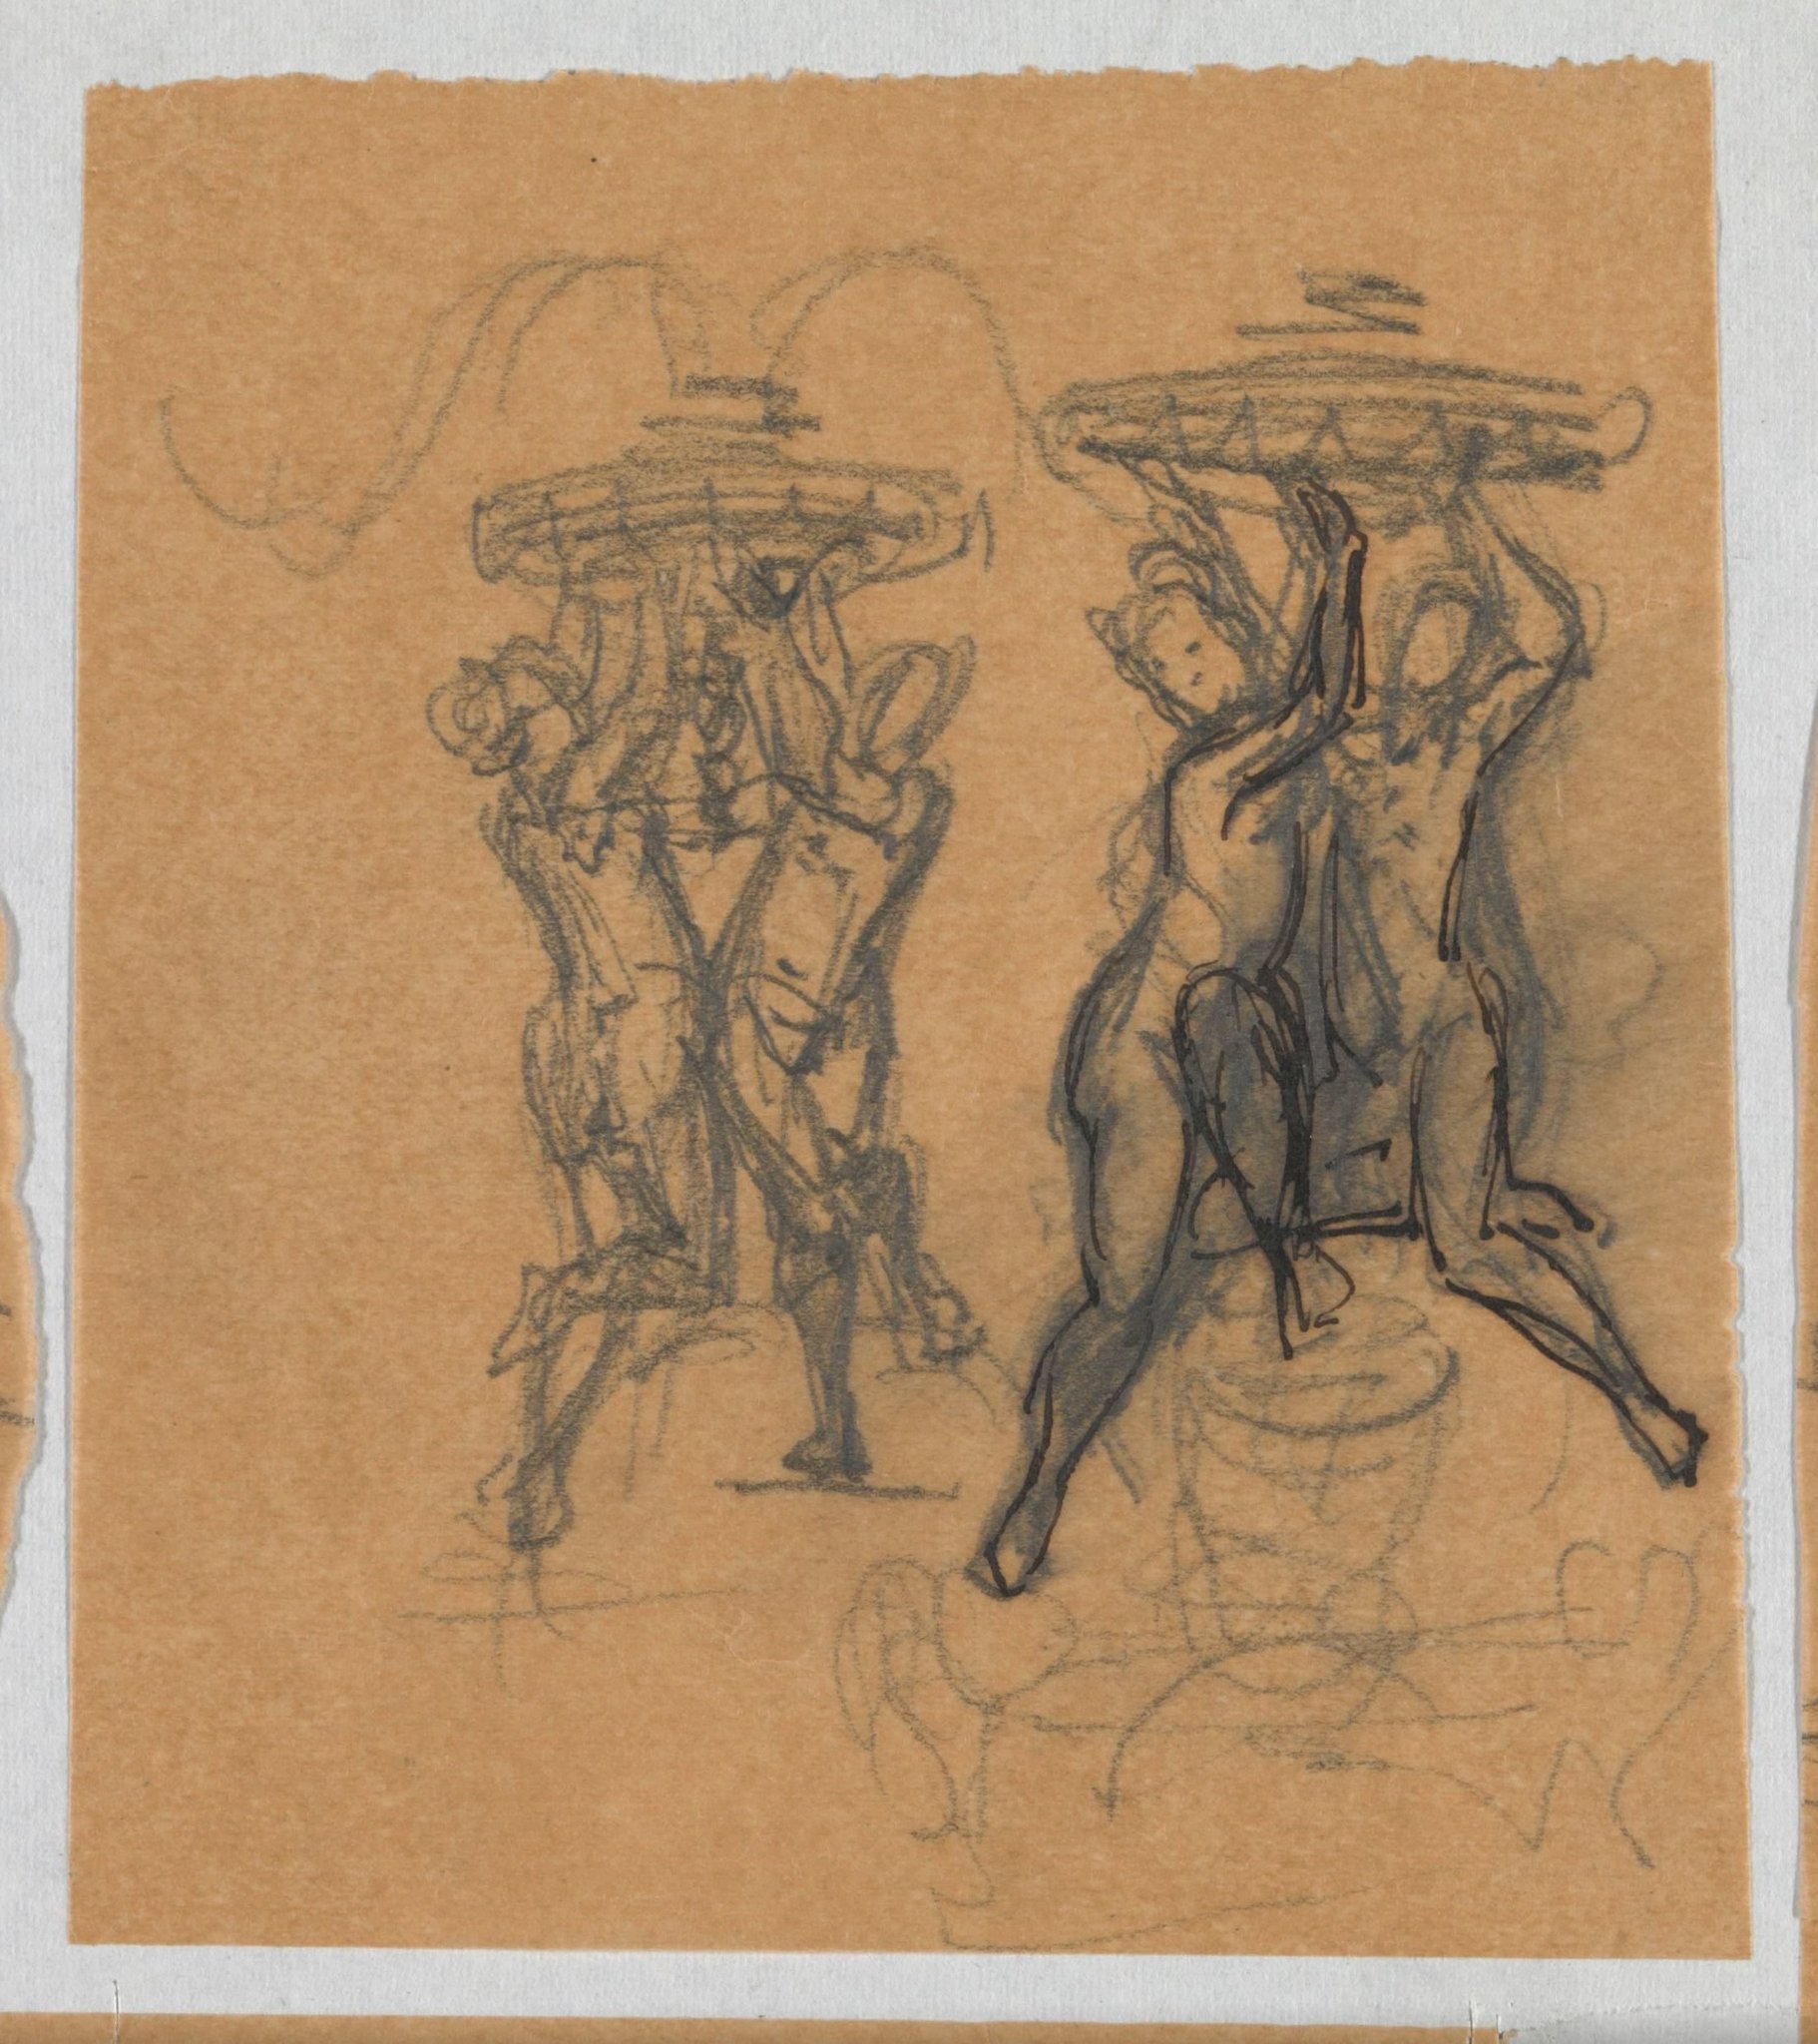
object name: design drawing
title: Ontwerp voor twee schachten met figuren van kandelabers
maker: henri cameré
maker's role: designer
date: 1864-1894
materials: ink, pencil, paper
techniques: pen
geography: paris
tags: chandelier, candelabrum